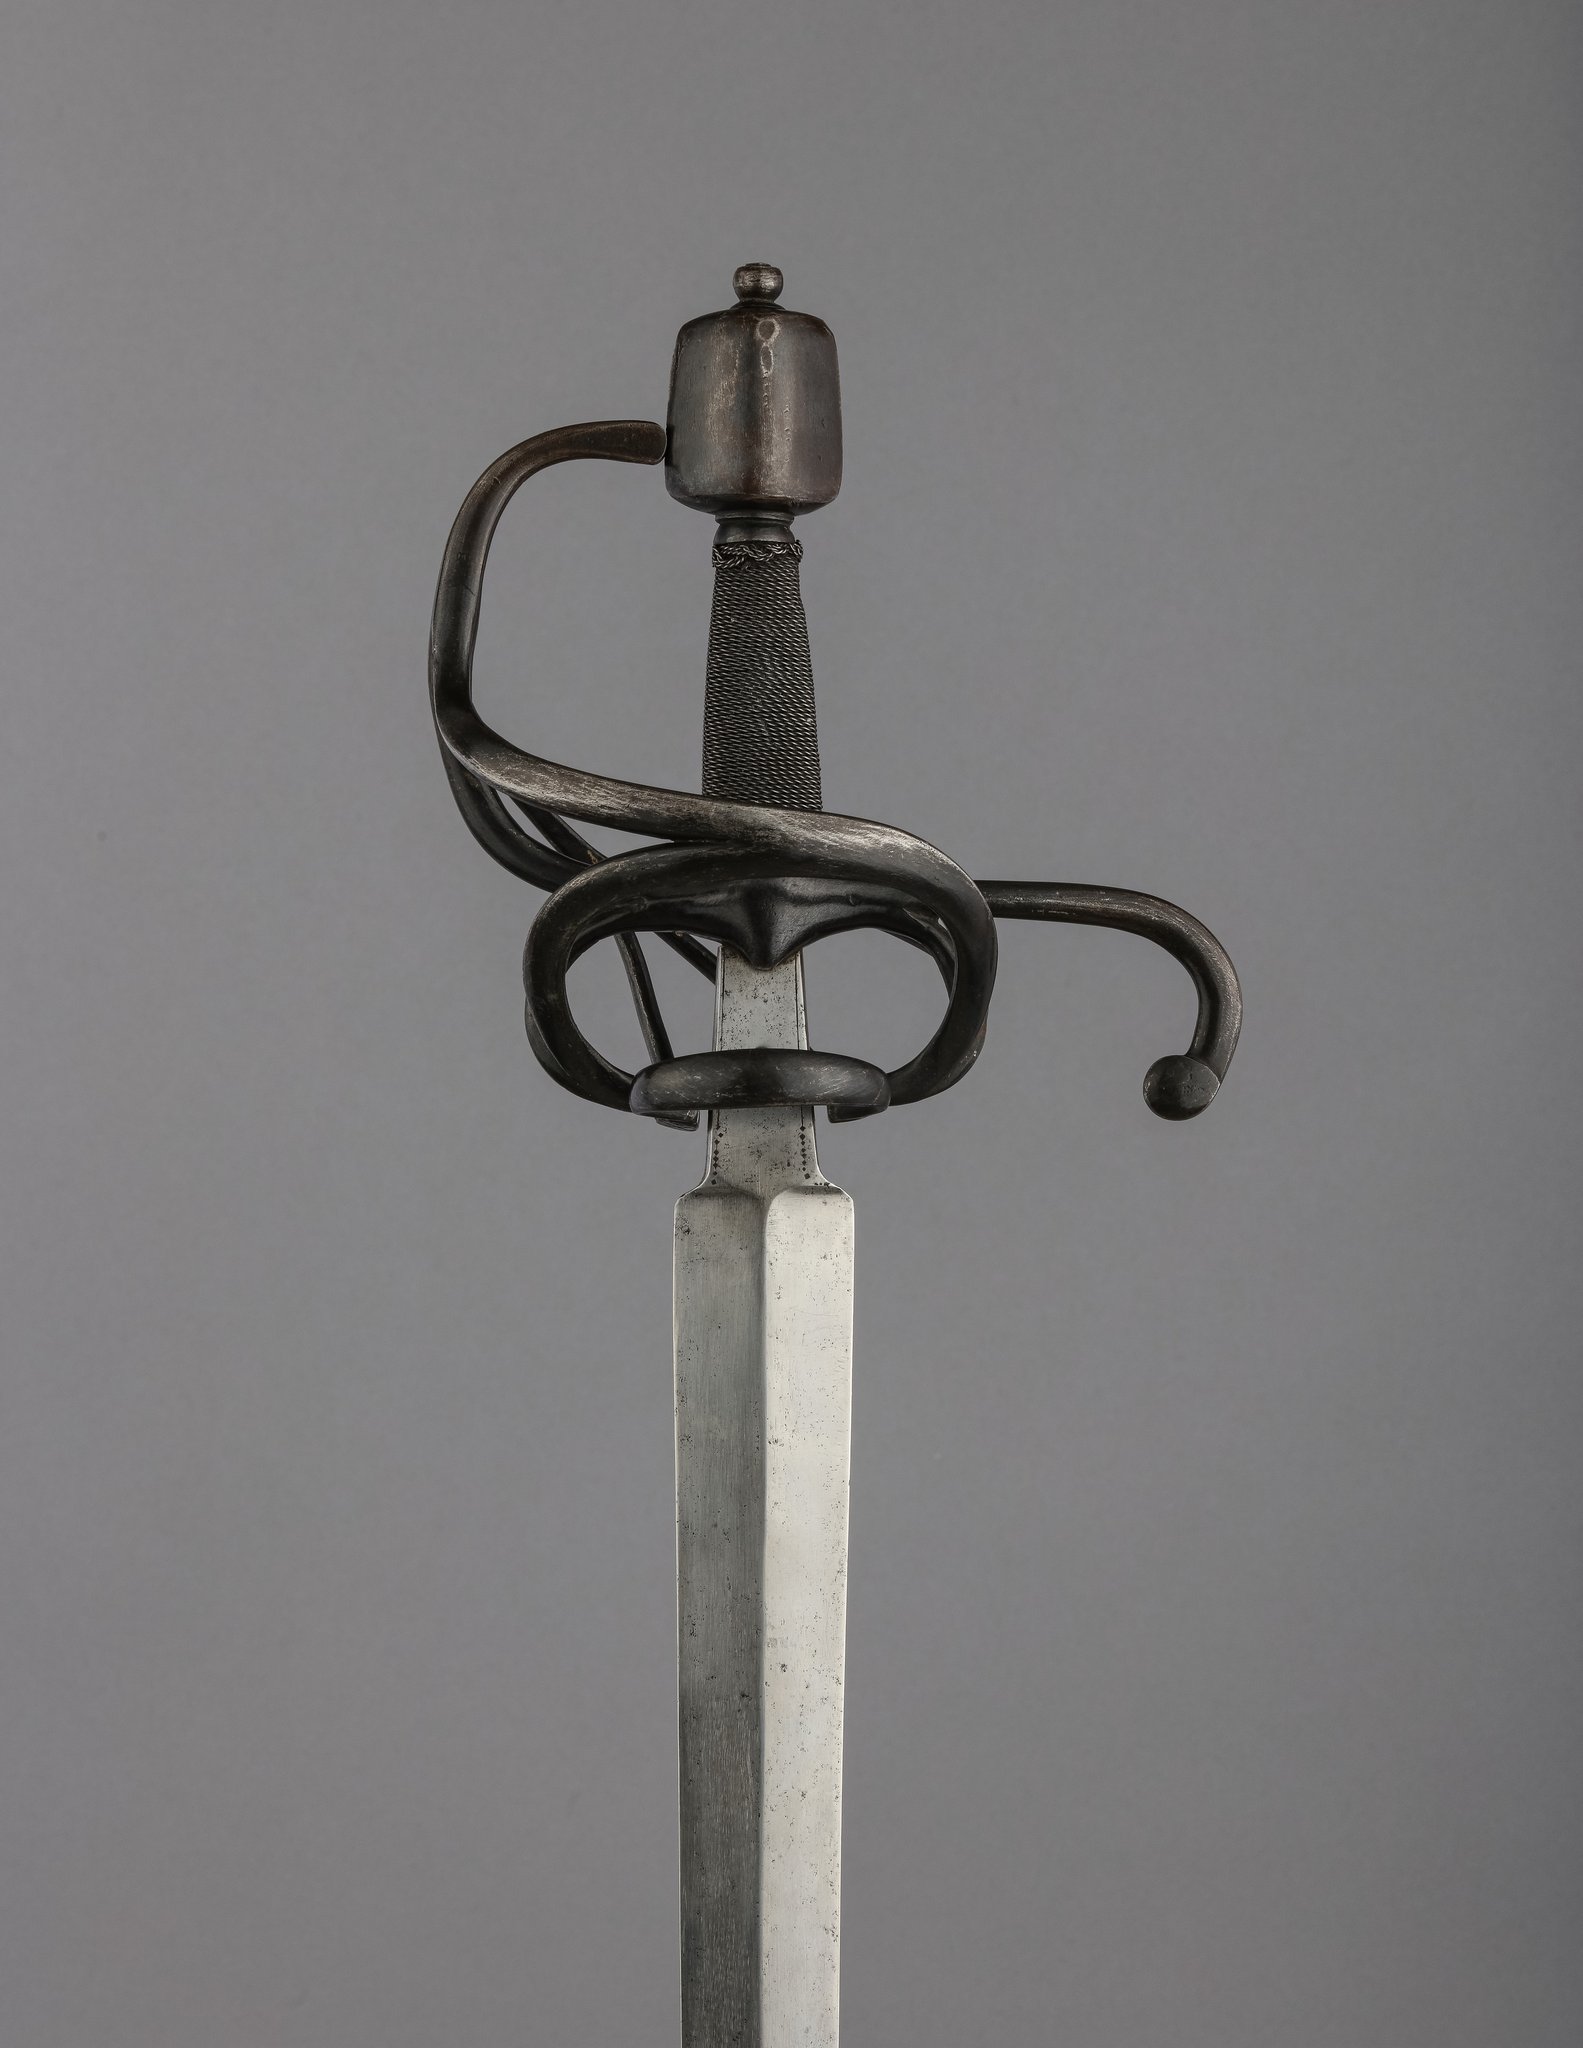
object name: rapier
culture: german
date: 1600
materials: steel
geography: germany